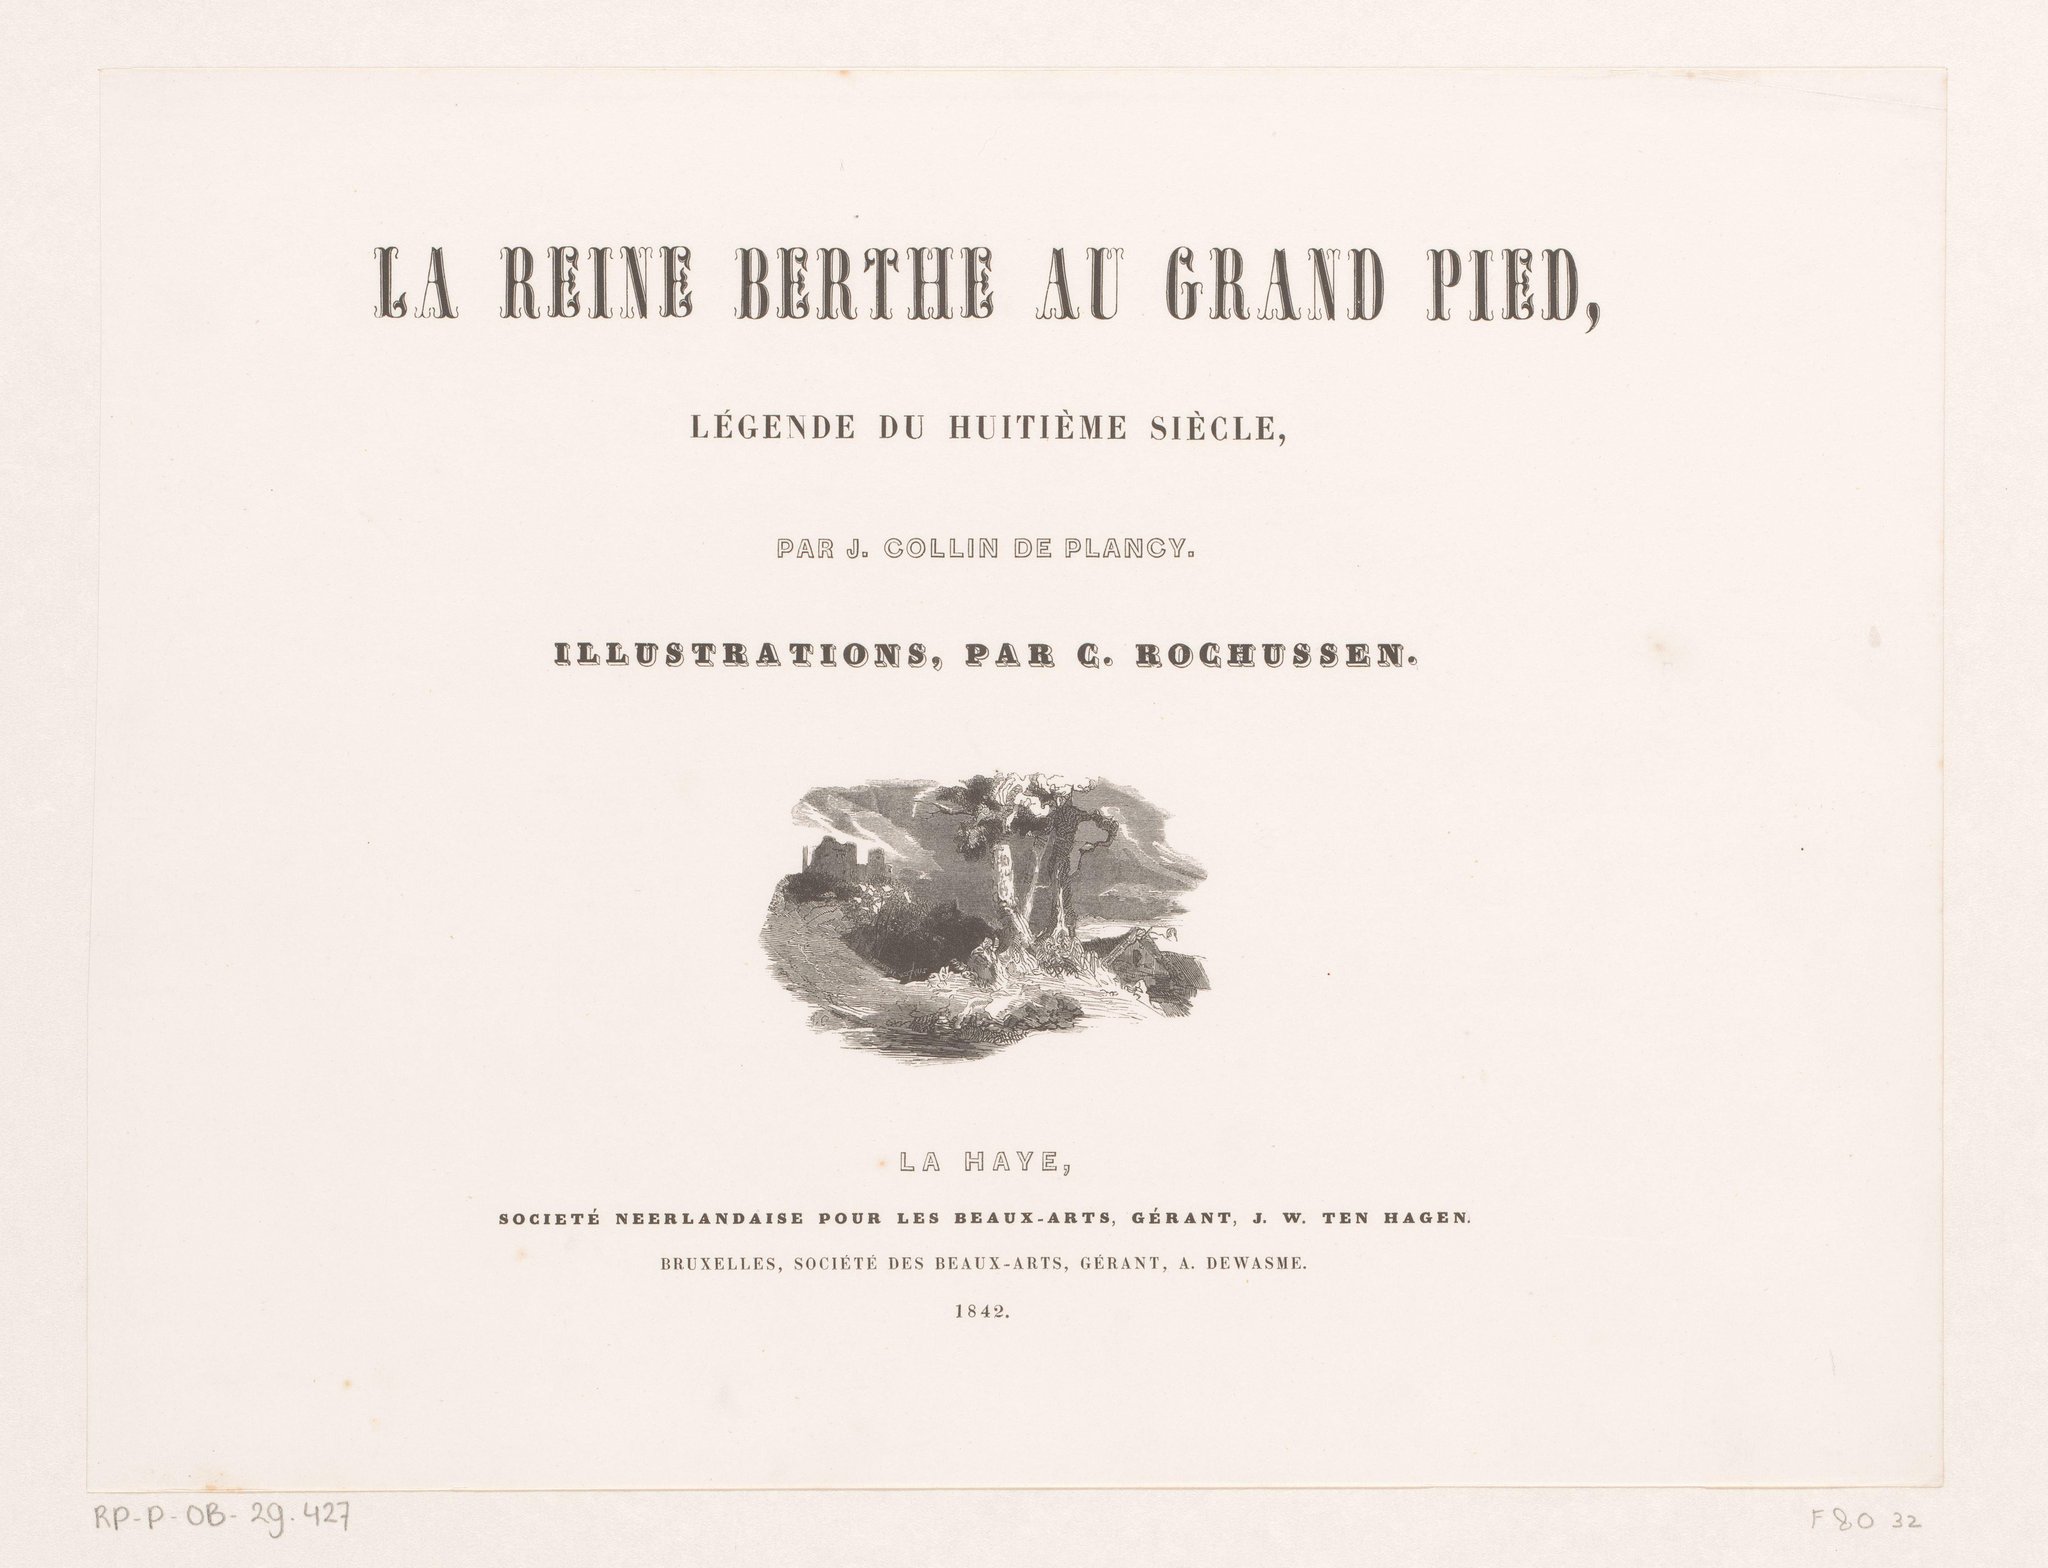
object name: titelblad, titelpagina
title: Titelpagina voor: Jacques Collin de Plancy, La Reine Berthe au grand pied, 1842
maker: charles rochussen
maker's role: draughtsman, painter, print maker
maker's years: 1814-1894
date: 1842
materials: paper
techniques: lithograph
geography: the hague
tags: landscapes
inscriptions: collector's mark: Lugt 2228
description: Titelpagina voor: Plancy, Jacques Collin de. La Reine Berthe au grand pied. Den Haag: Nederlandsche Maatschappij van Schoone Kunsten, 1842.